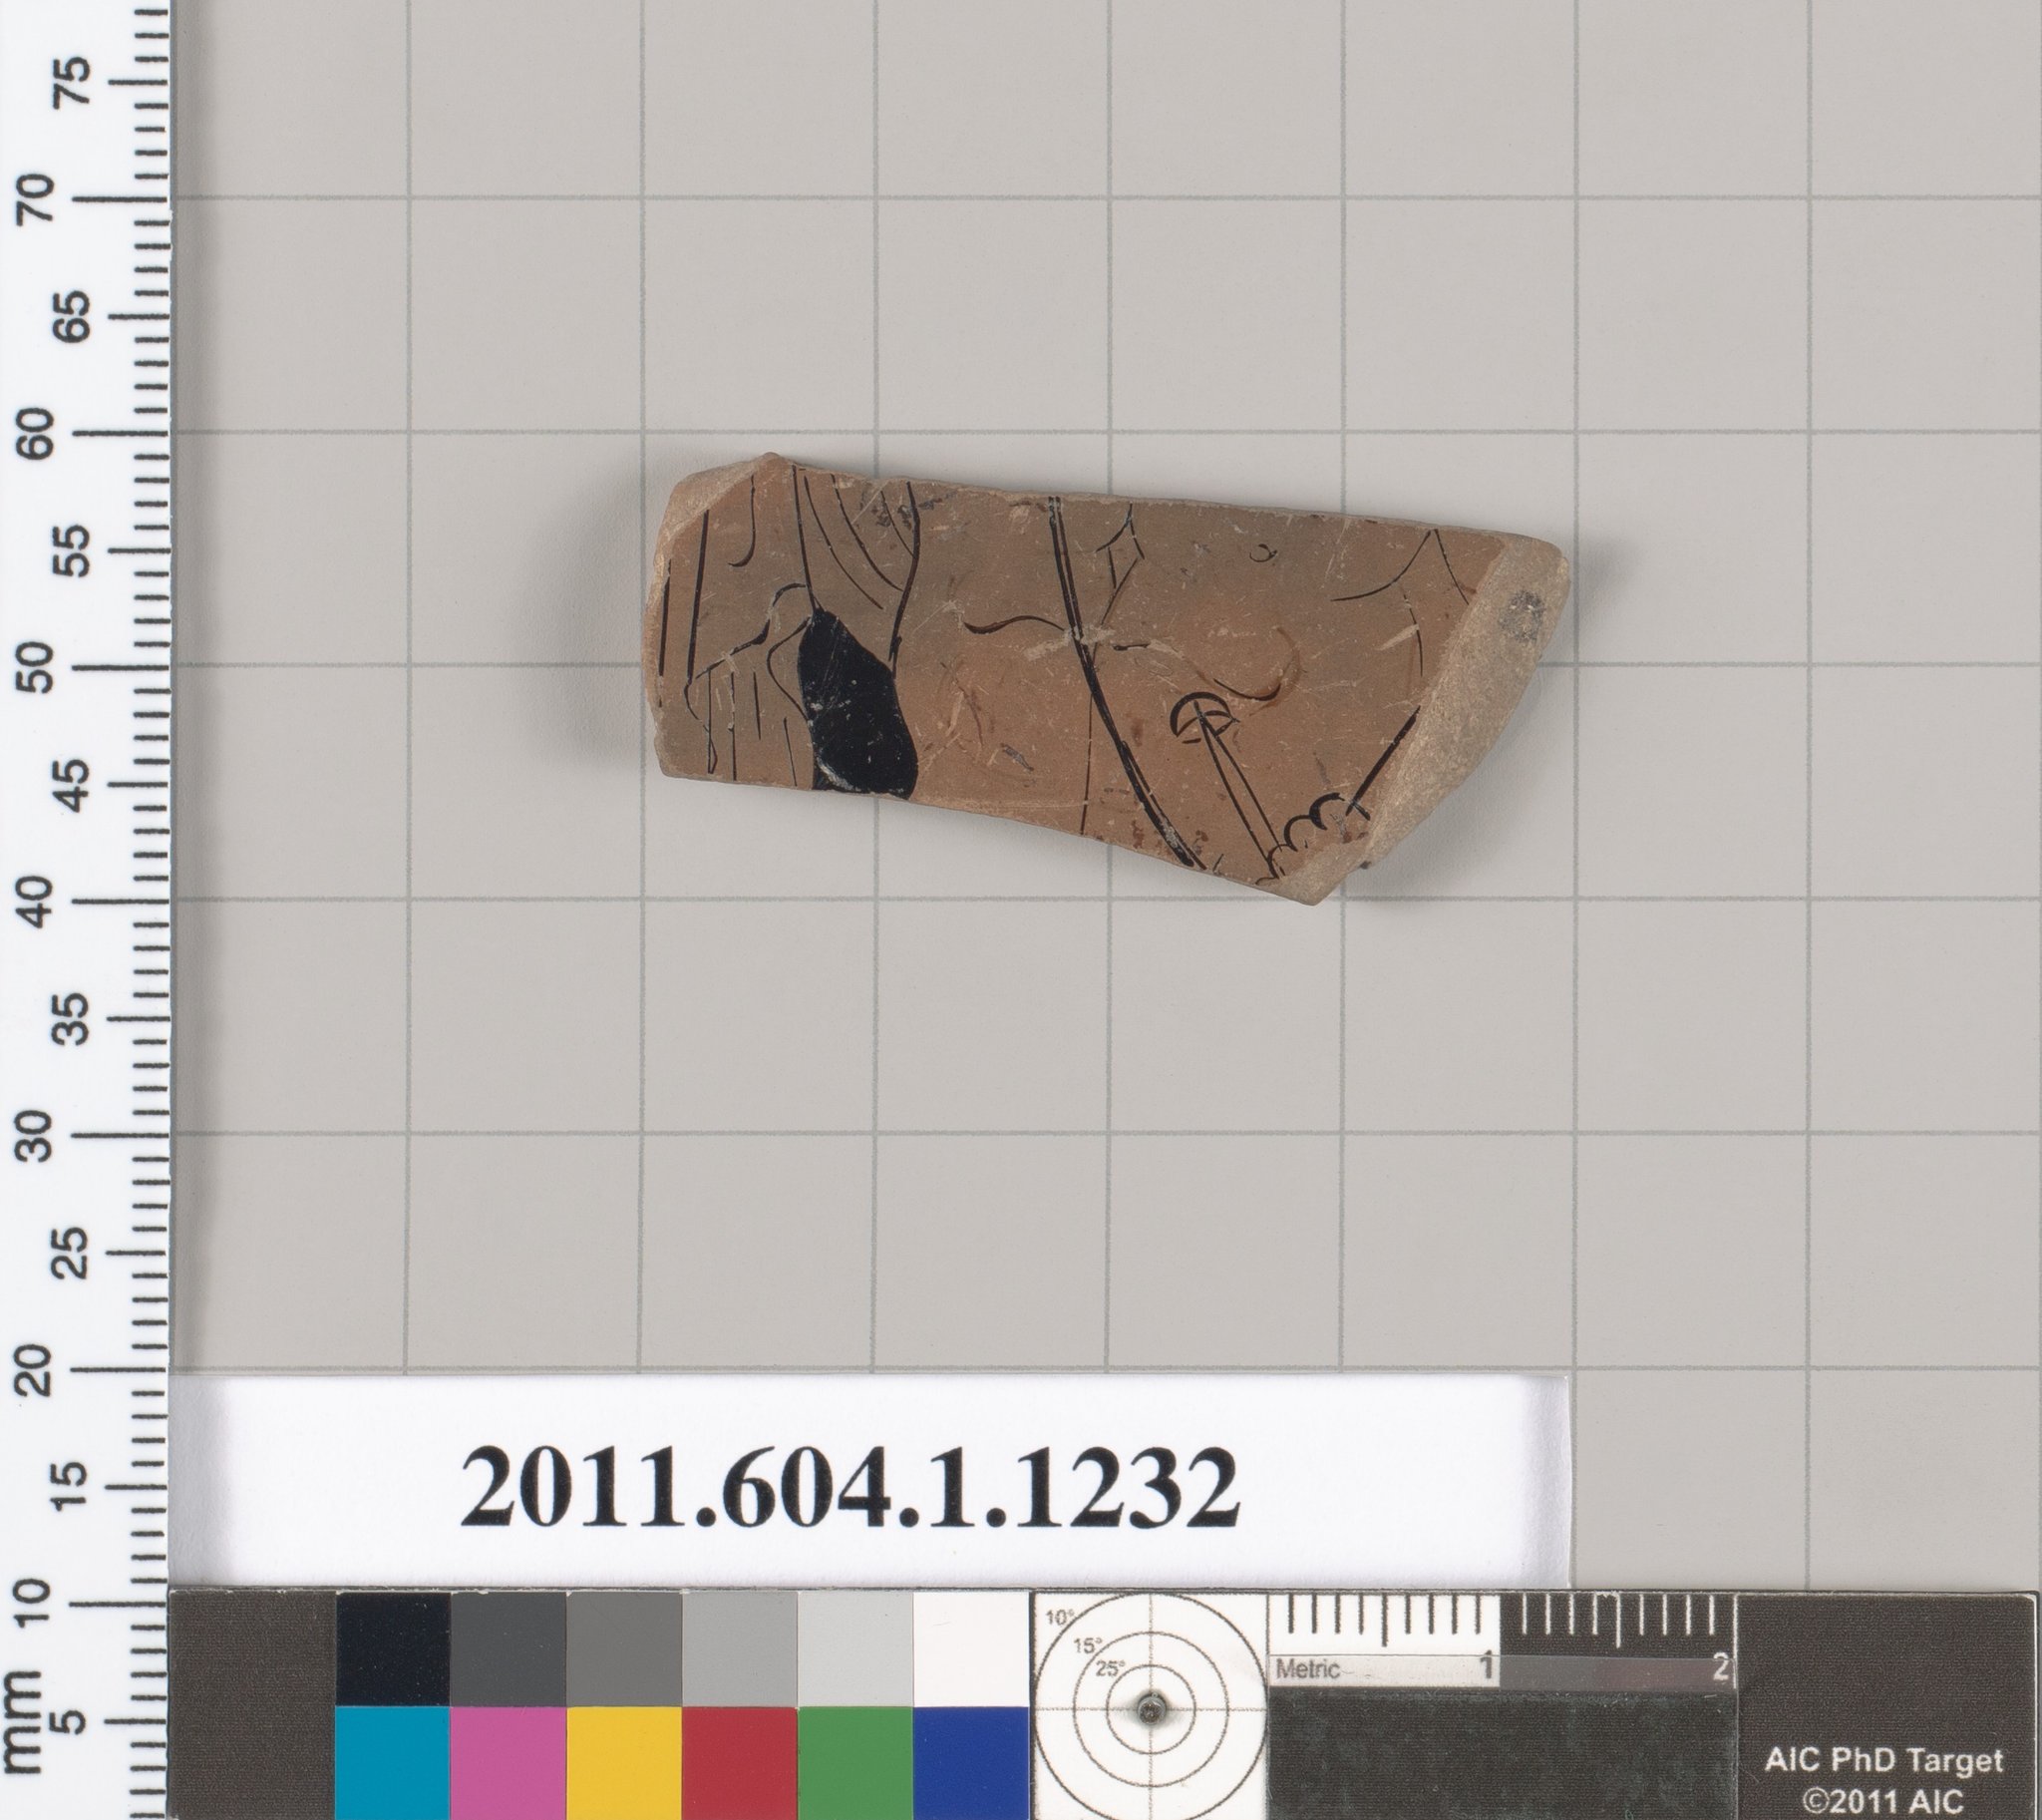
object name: kylix fragment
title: Terracotta fragment of a kylix (drinking cup)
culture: greek, attic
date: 467-435 BCE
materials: terracotta